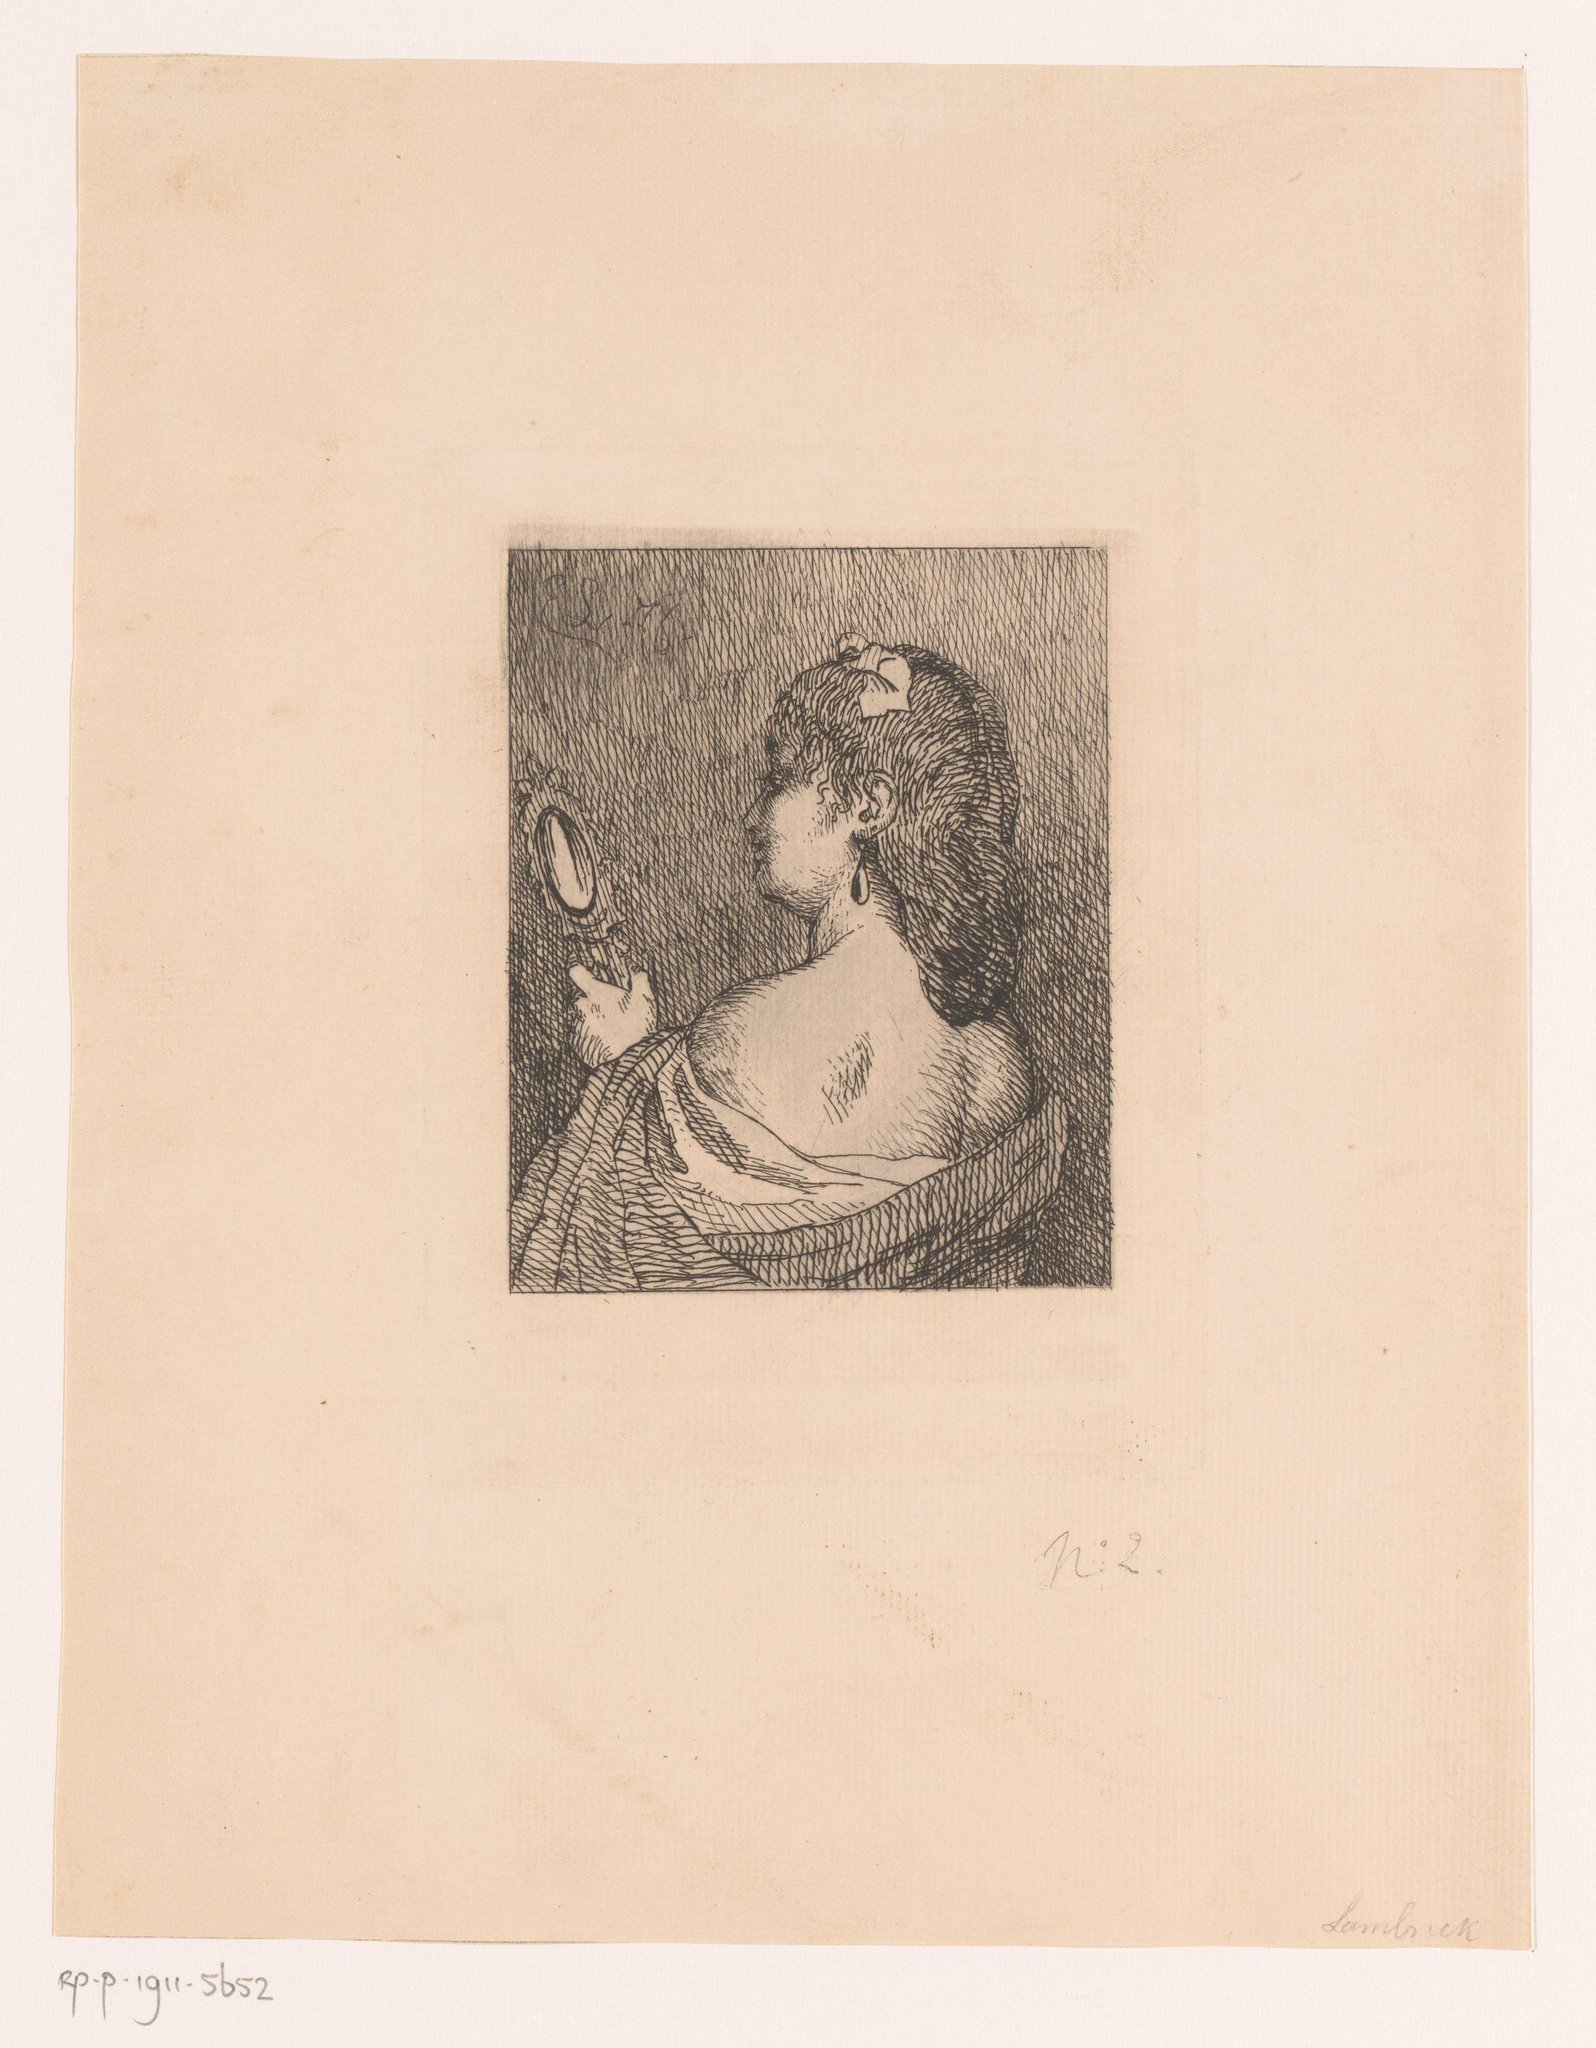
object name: print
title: Vrouw kijkt in een spiegel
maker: edmond lambrichs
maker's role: print maker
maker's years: 1830-1887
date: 1876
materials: paper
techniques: etching, intaglio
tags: looking in the mirror; contemplation of own beauty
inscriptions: collector's mark: Lugt 2228, annotation: ‘No. 2’